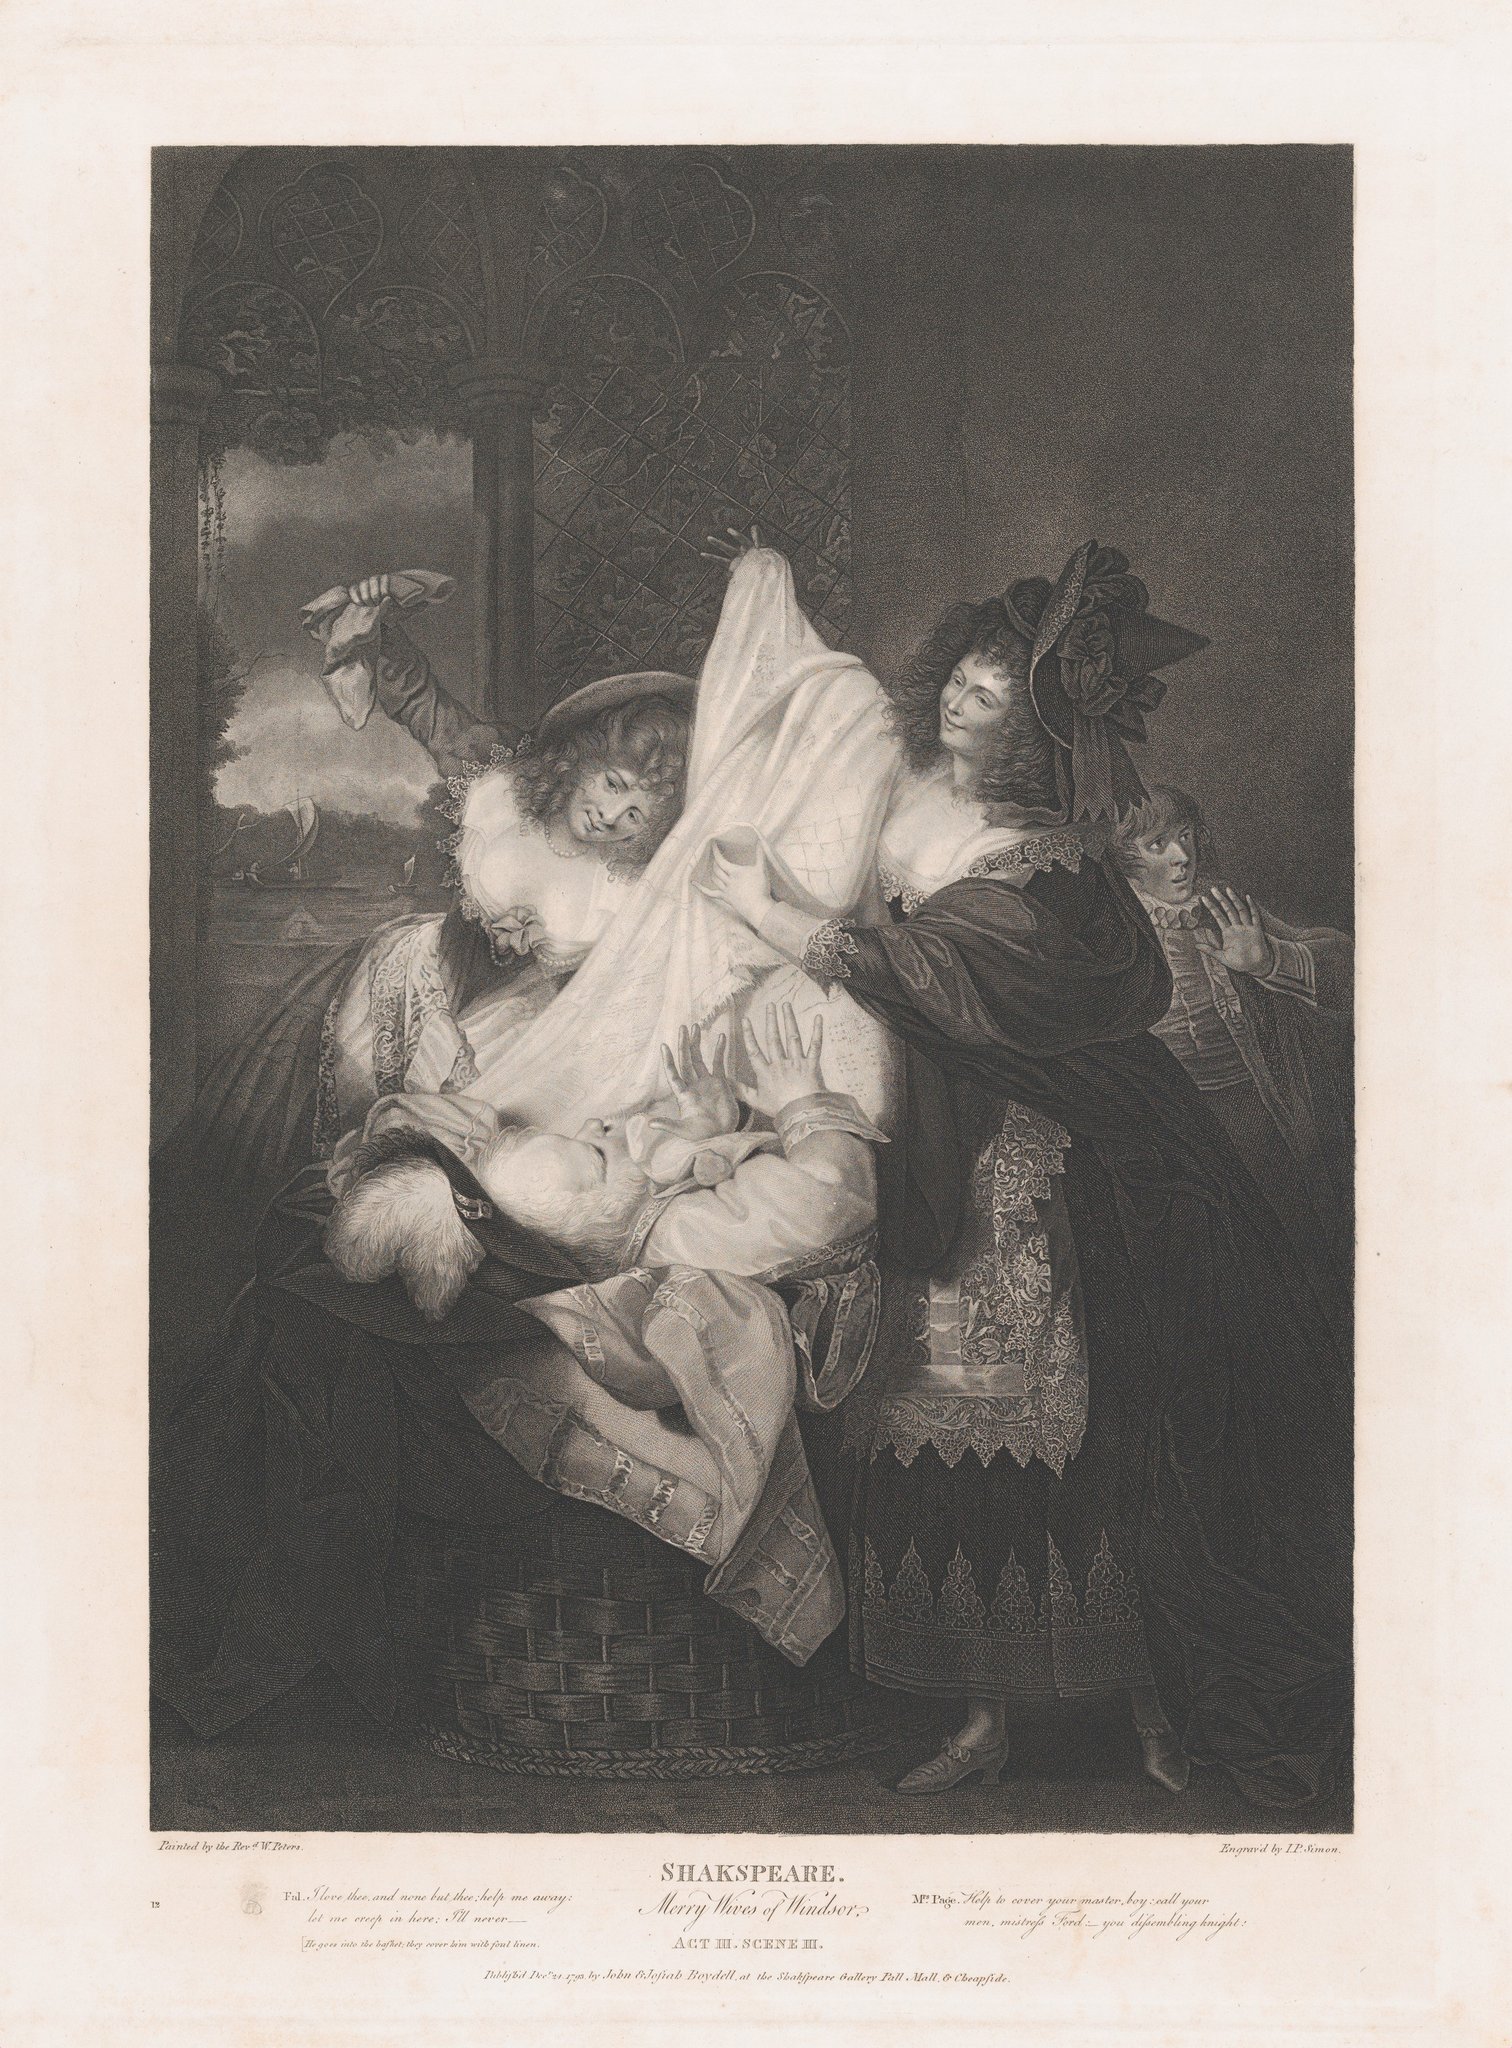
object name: print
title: Falstaff in the Buck Basket (Shakespeare, Merry Wives of Windsor, Act 3, Scene 3)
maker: peter simon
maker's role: engraver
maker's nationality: british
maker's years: 1764-1813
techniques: engraving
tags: shakespeare,men,women